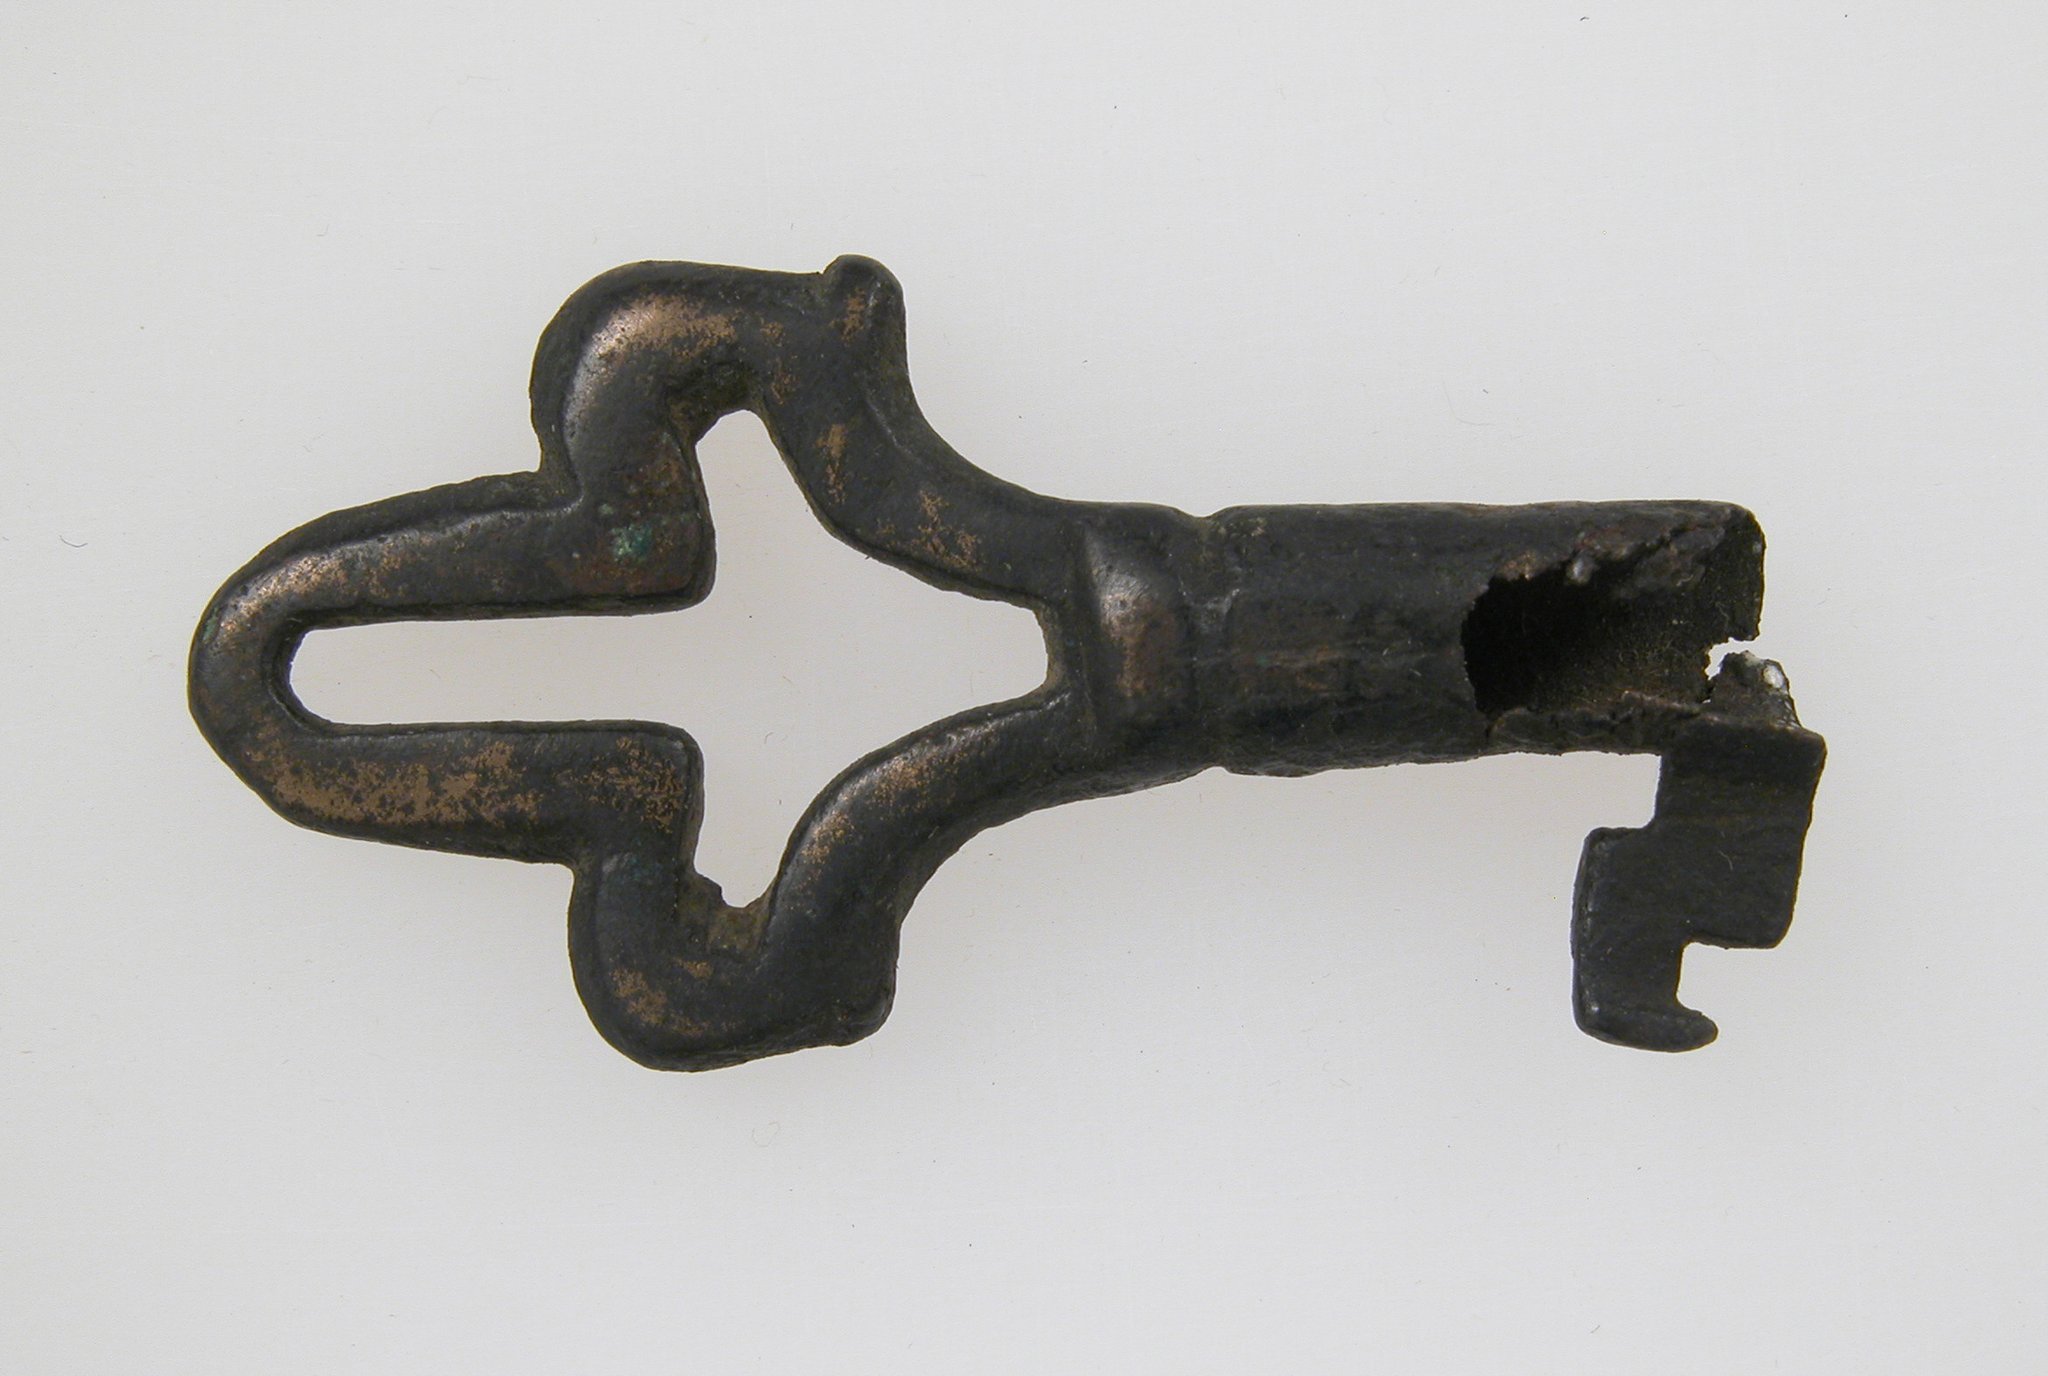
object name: key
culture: french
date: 1501-1600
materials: copper alloy